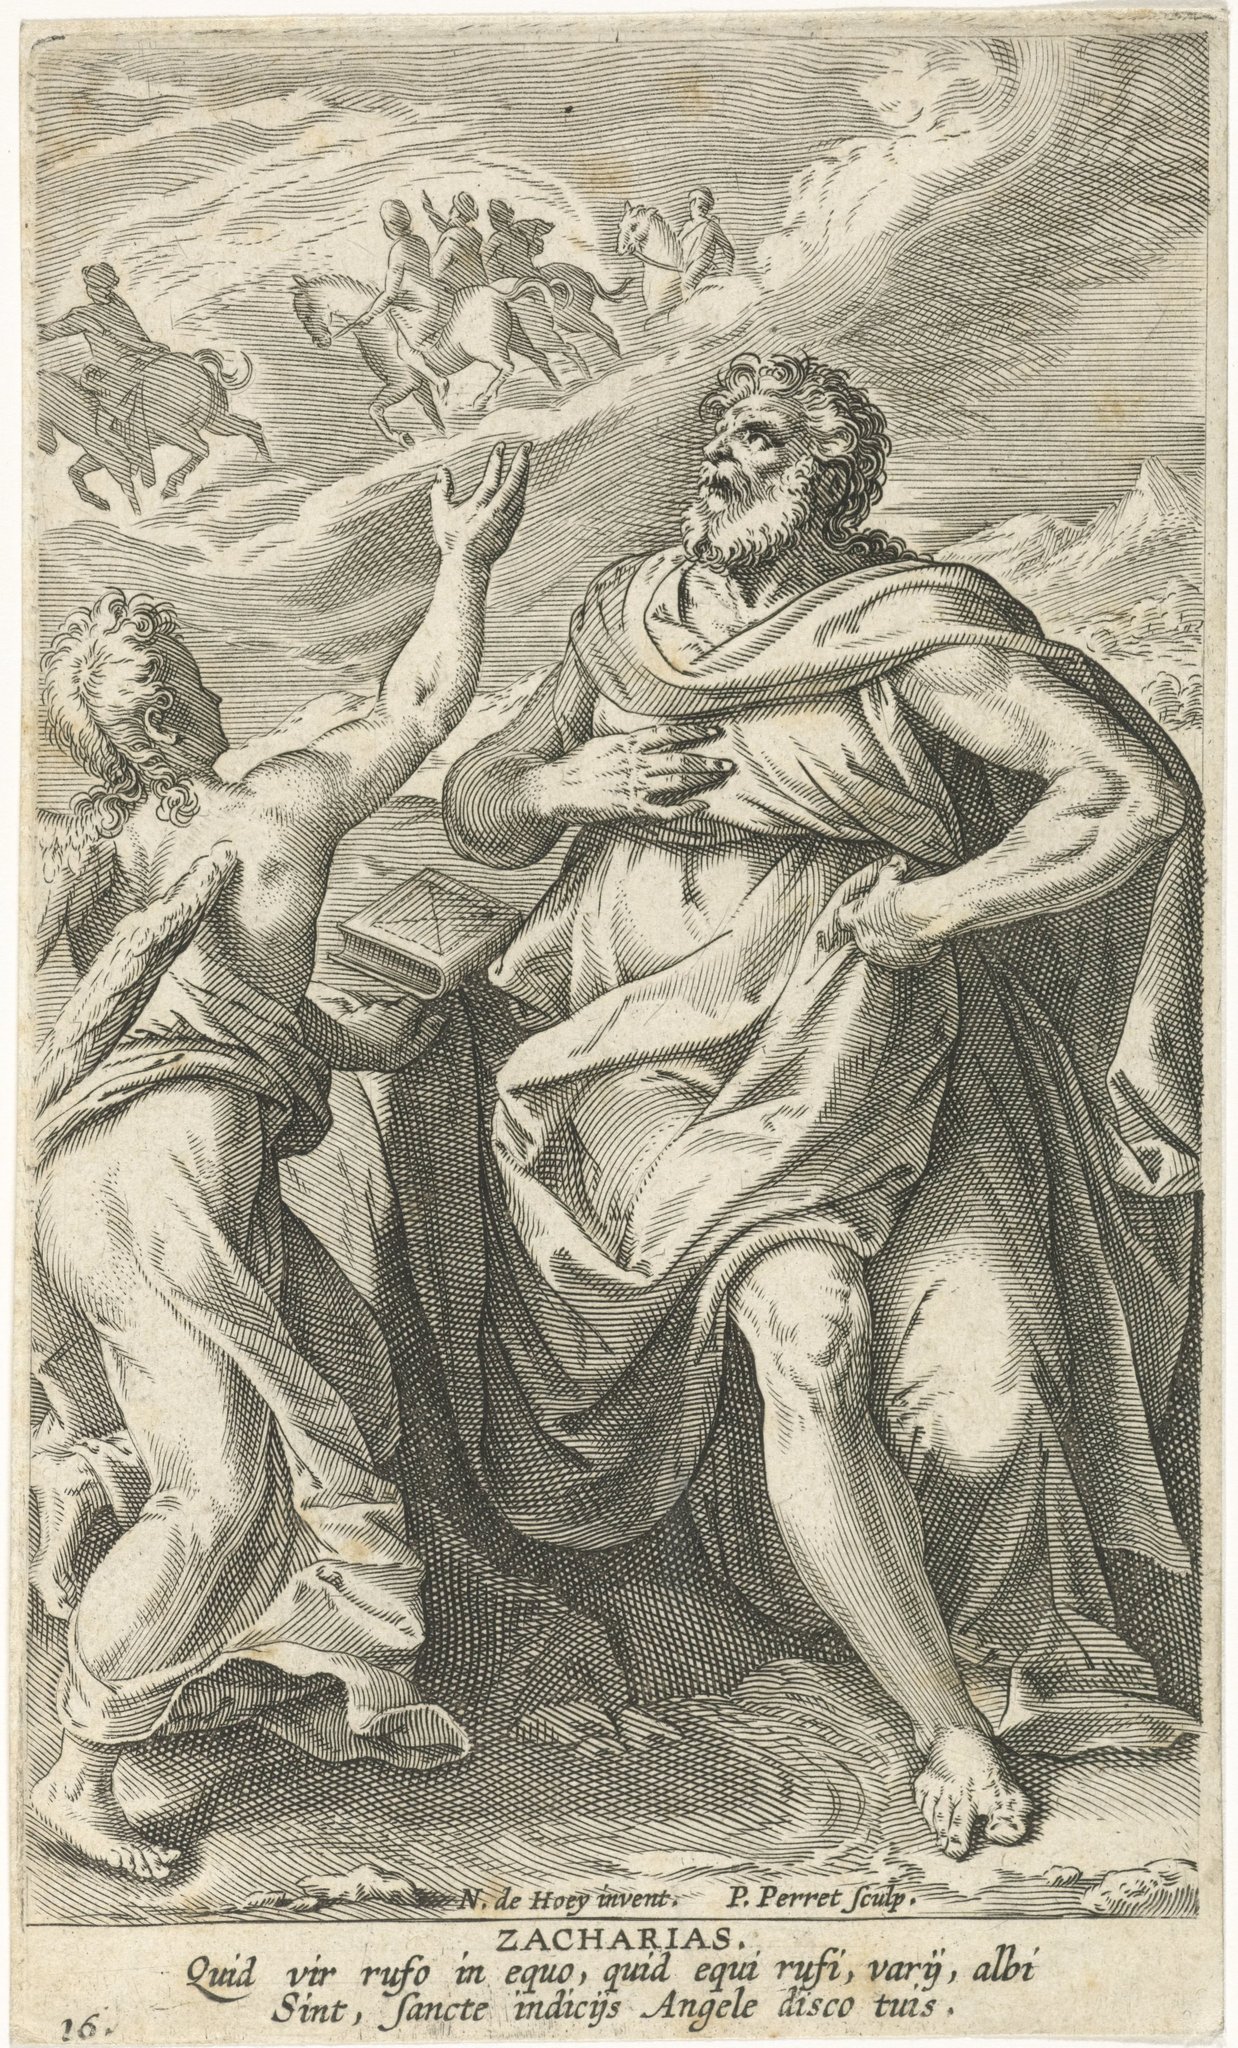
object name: print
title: Icones prophetarum majorum et minorum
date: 1594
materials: paper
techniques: engraving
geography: antwerp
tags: persons from the old testament (not in biblical context, nor occurring in legendary/historical extensions included in division 71)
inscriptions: collector's mark: Lugt 2228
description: Landschap met Zacharias, vergezeld door een engel die naar de hemel wijst, waar een stoet ruiters voorbijtrekt. In de marge een tweeregelig onderschrift in het Latijn.